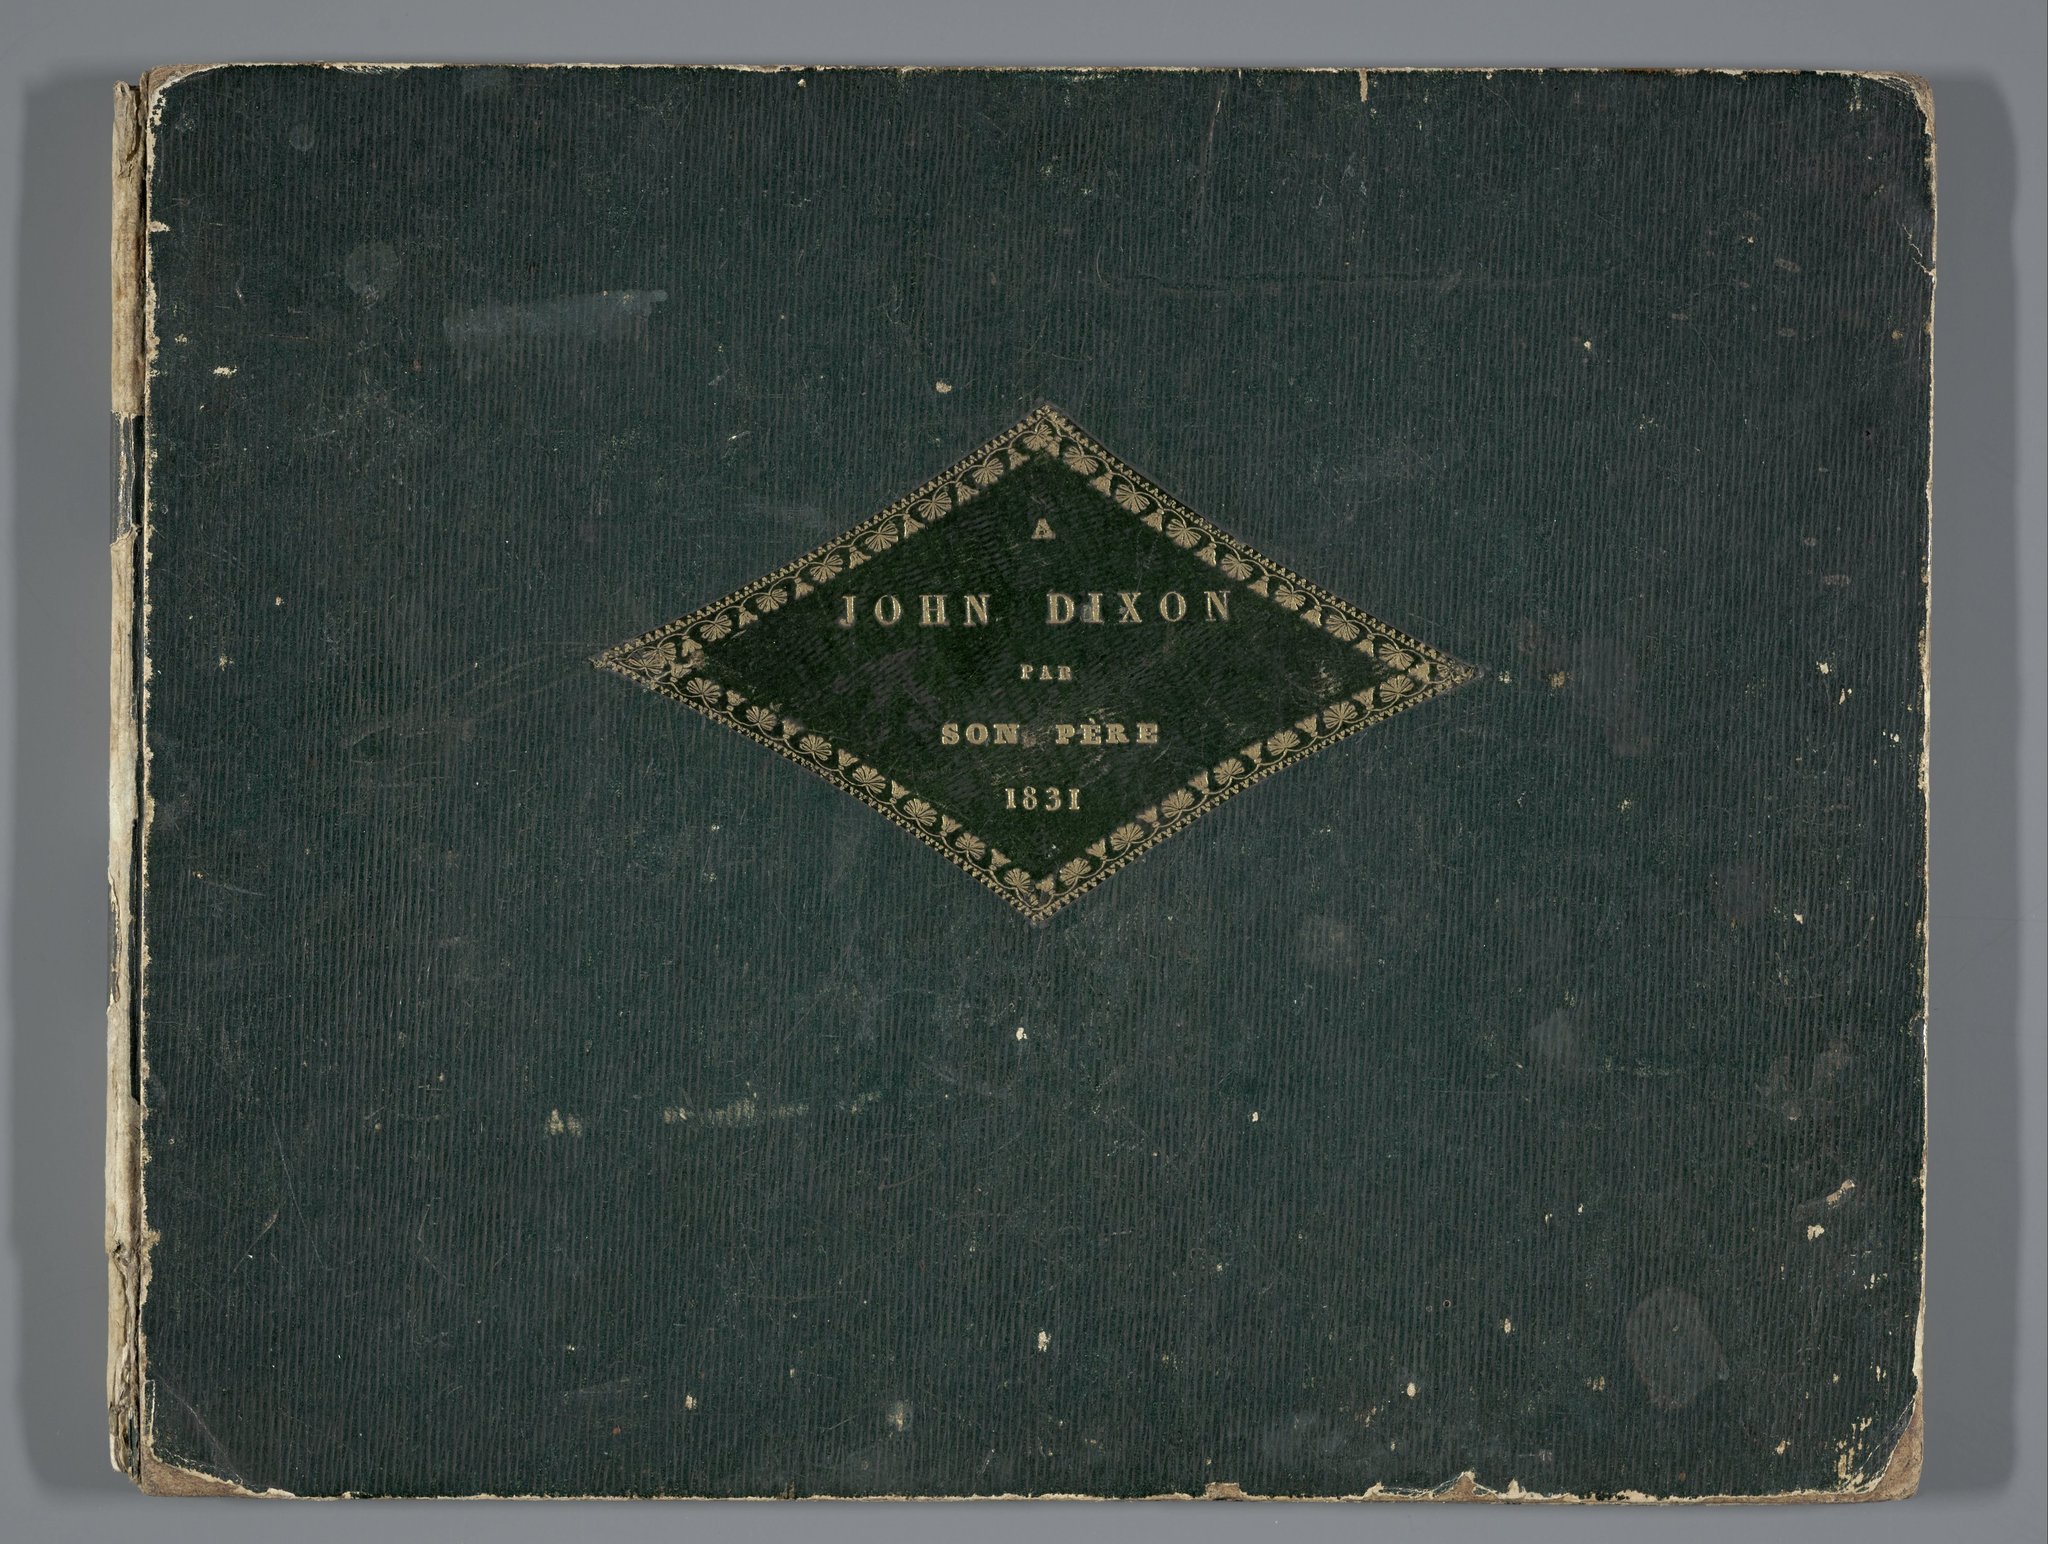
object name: prentrecueil, prentenalbum, prentalbum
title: Album met litho's naar J.C. Schotel, E.J. Verboeckhoven en anderen, met op het omslag een gedrukte opdracht, gedateerd 1831, van de fabrikant Job Dixon aan zijn zoon John Dixon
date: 1830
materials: paper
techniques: lithograph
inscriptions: : ‘A / JOHN DIXON / PAR / SON PÈRE / 1831’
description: Album met twaalf vroege lithografieën geproduceerd door de firma Dewasme-Pletinckx te Brussel naar J.C. Schotel, E.J. Verboeckhoven, B.J. van Hove en andere eigentijdse meesters in originele band.